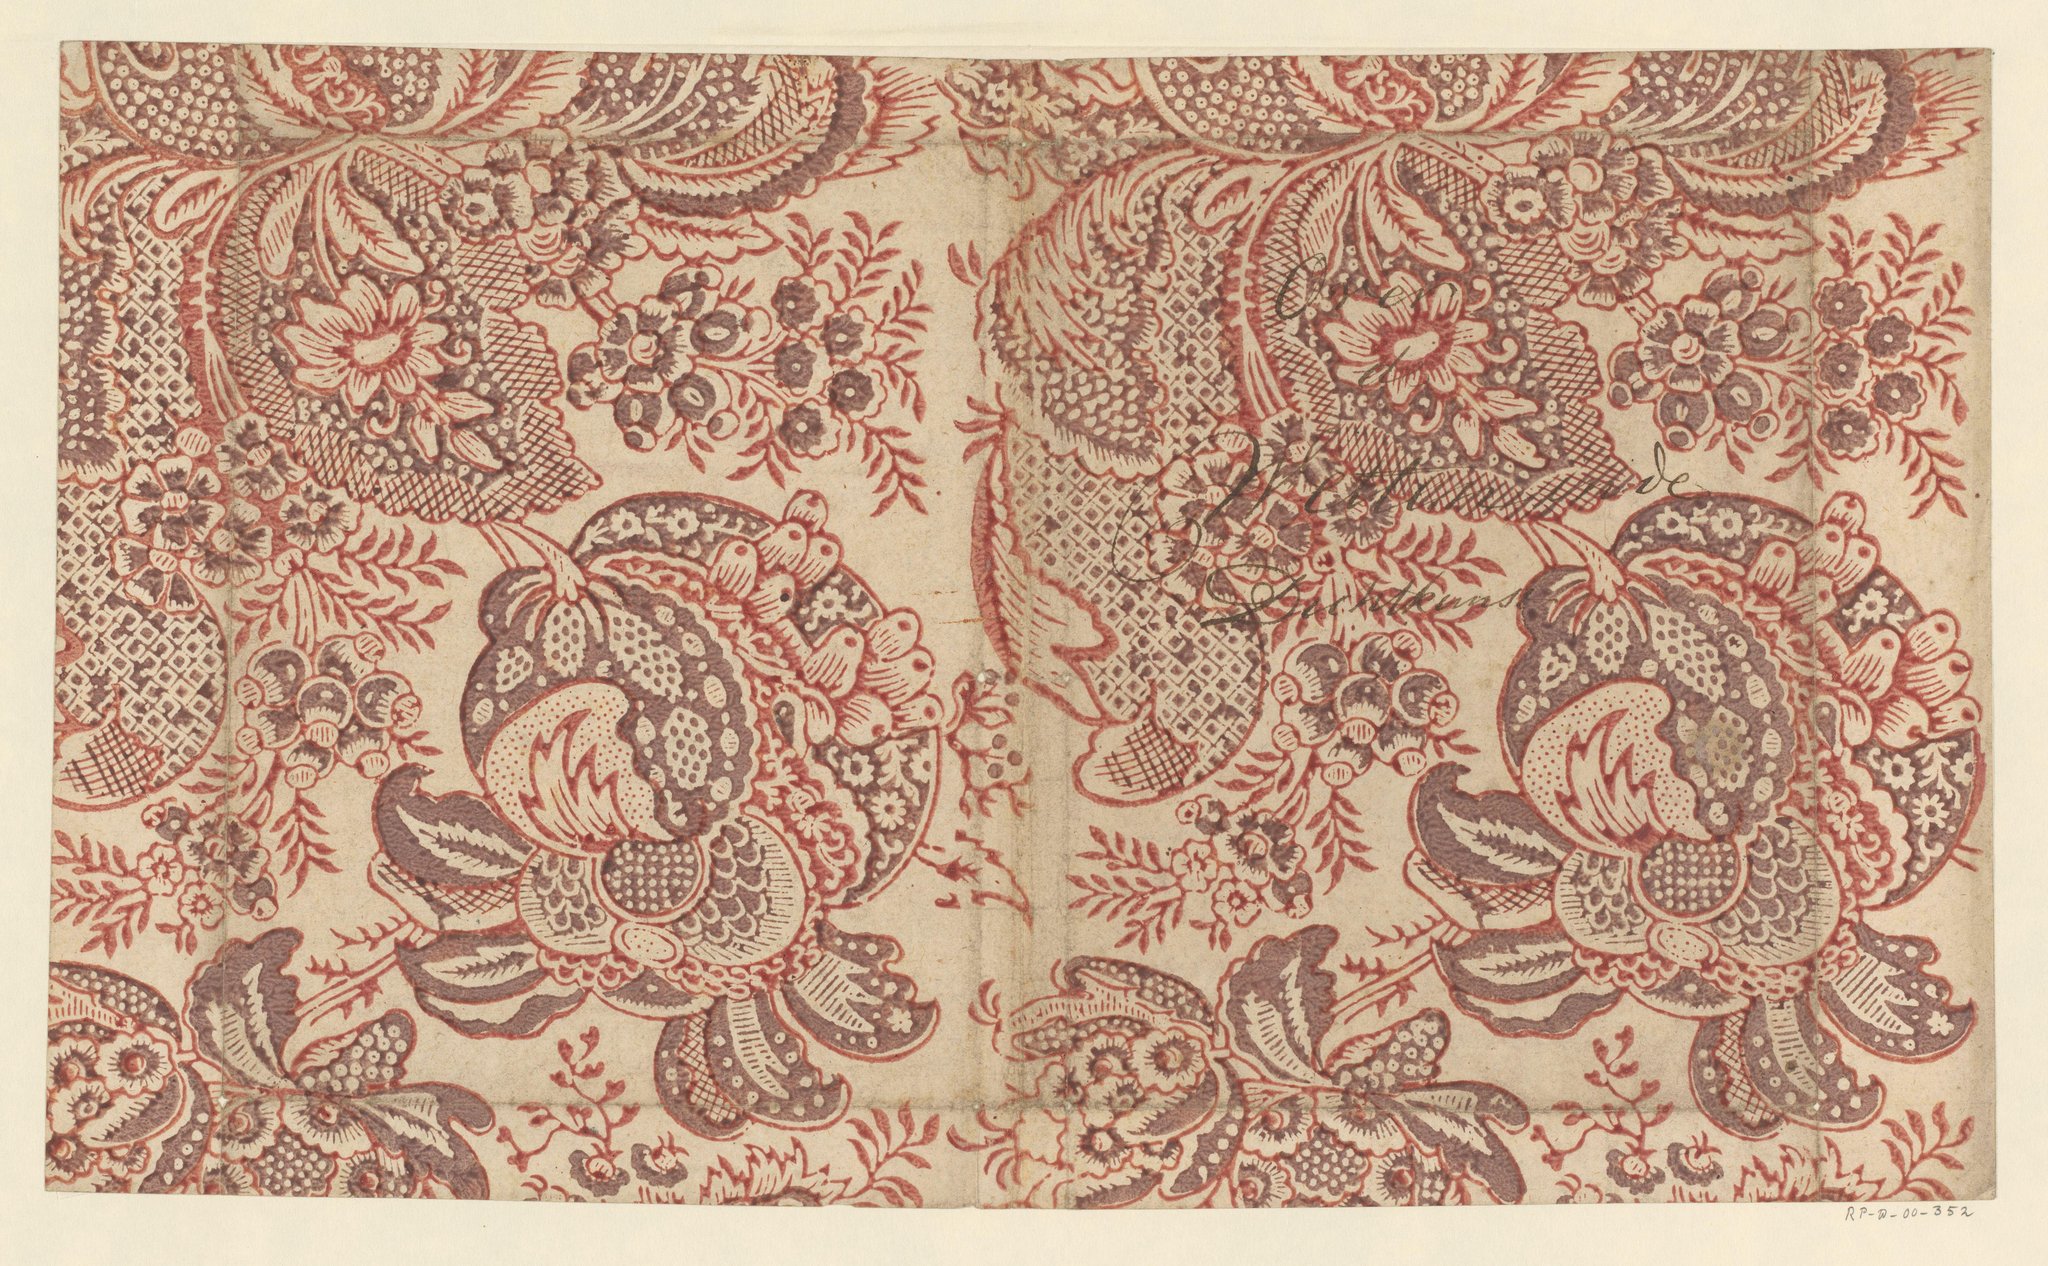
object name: wrapper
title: Blad met regelmatig patroon van bloemen met grote vruchten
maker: Anonymous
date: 1700-1800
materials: paper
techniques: printing block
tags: ornament derived from plant forms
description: Blad met regelmatig patroon van bloemen met grote vruchten, met opschrift 'Over de Wetten in de Dichtkunst'. Links en rechts identieke helften.